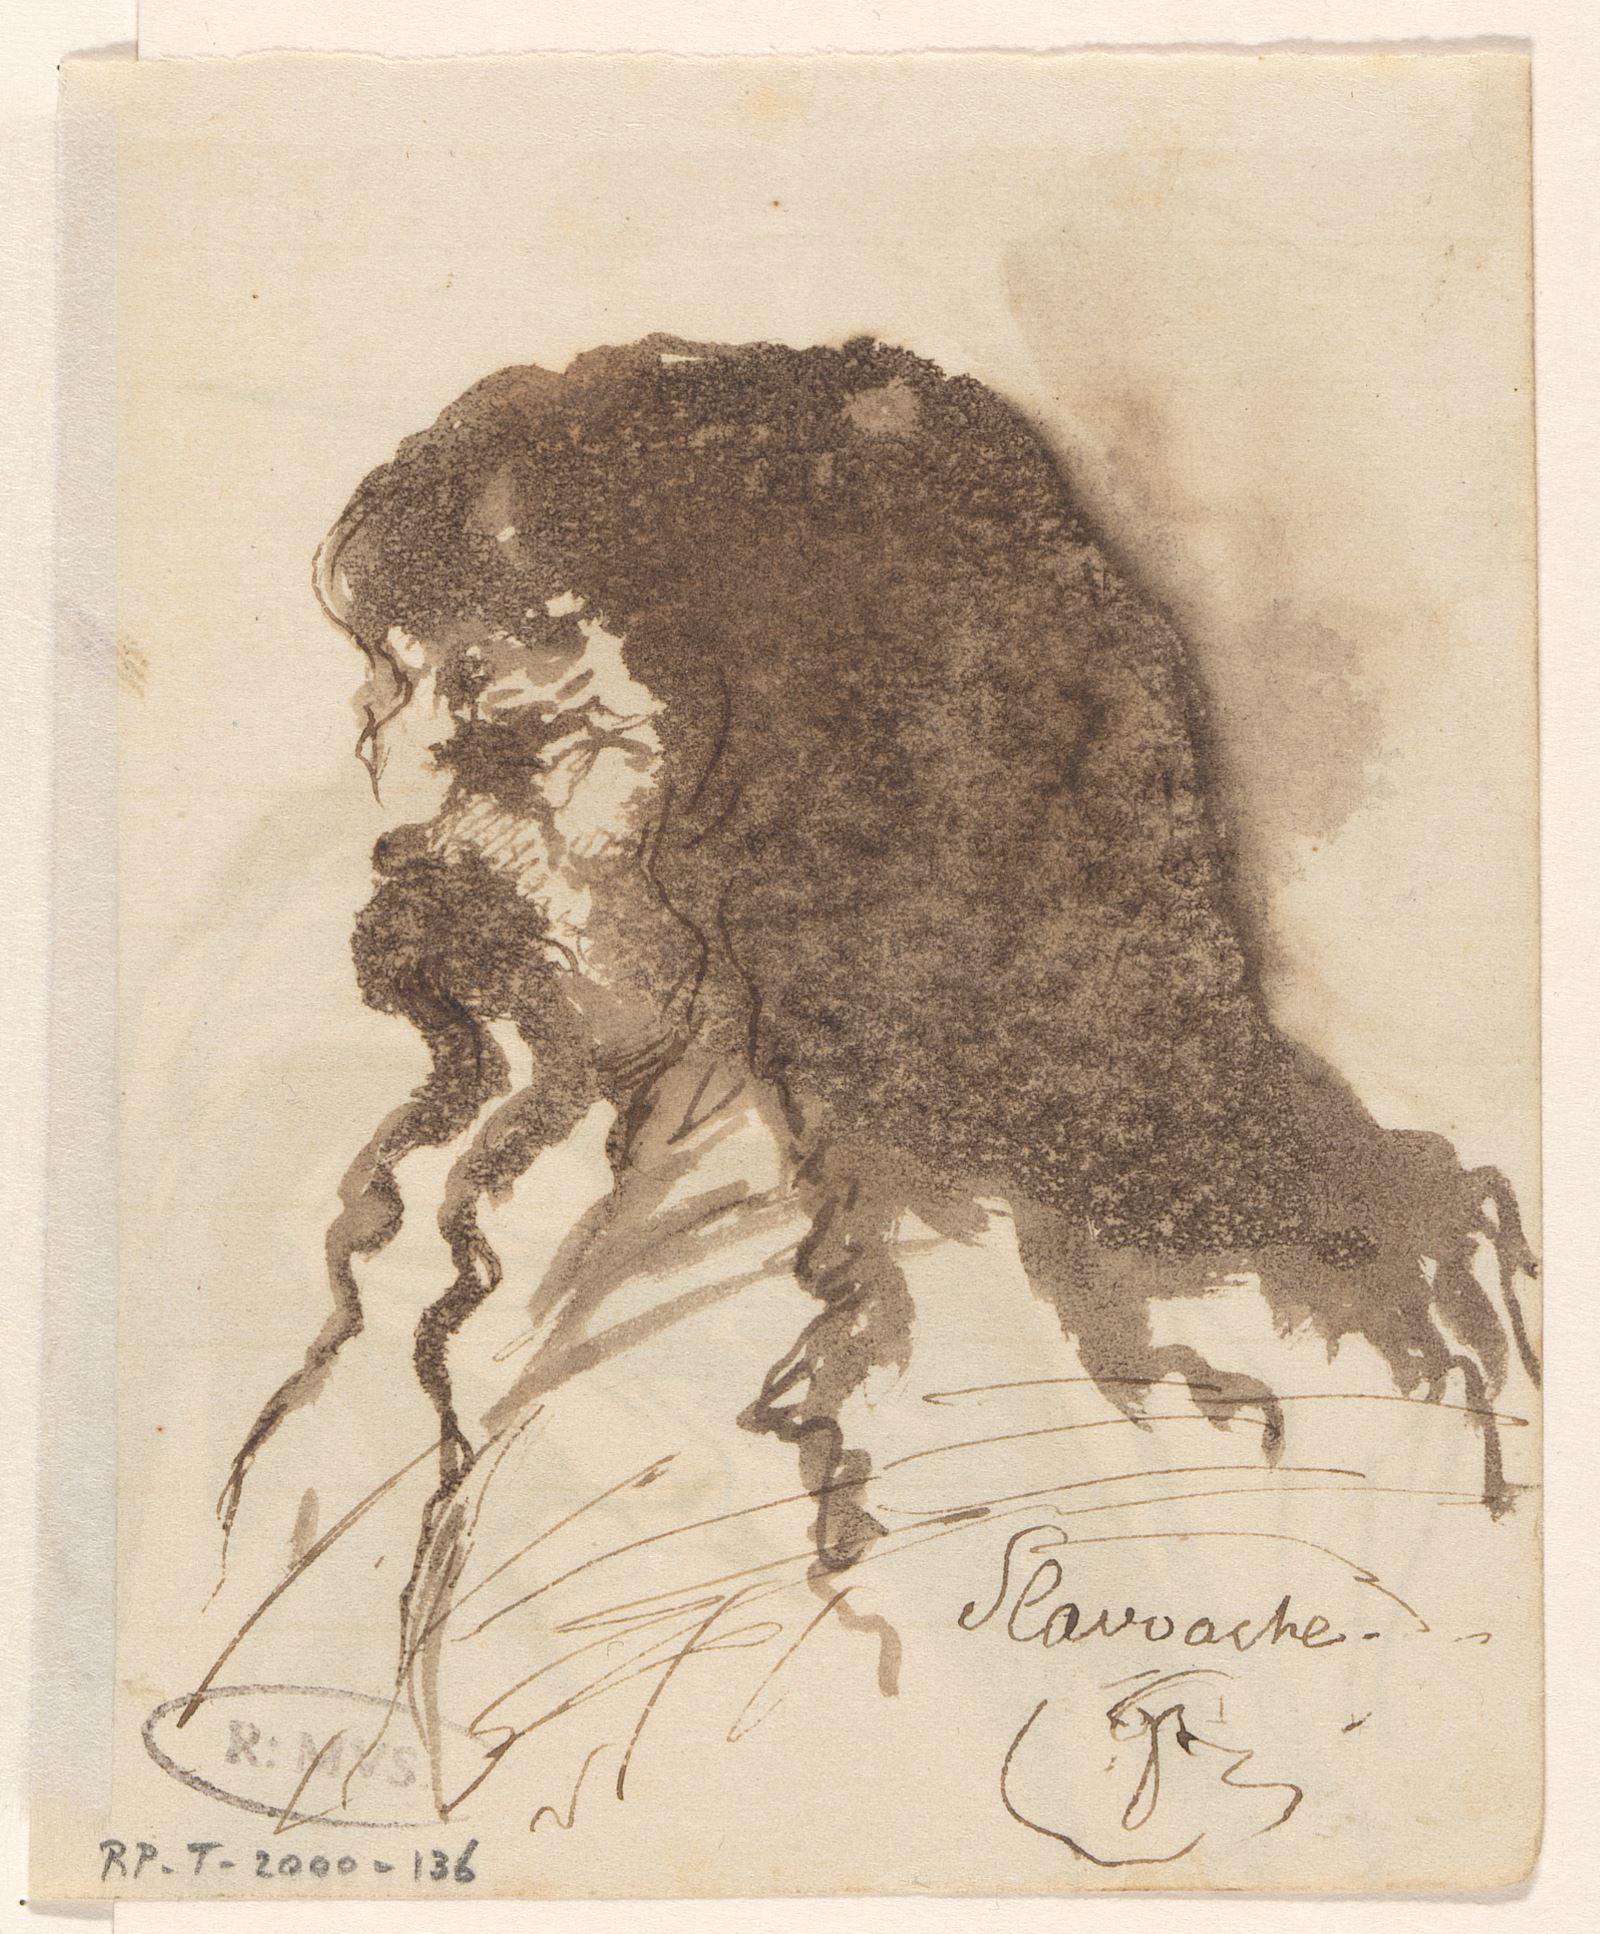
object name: drawing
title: Kop van een Slavoniër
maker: johannes tavenraat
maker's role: draughtsman, painter, print maker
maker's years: 1809-1881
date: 1807-1858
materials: ink, paper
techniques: brush, pen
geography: bohemia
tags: europeans (czechs), moustache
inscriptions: annotation: ‘Slavoache JT’, collector's mark: Lugt 2228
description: Kop van een man met lange haren en snor. Een inwoner van Bohemen, een Slowaak of een Slavoniër.